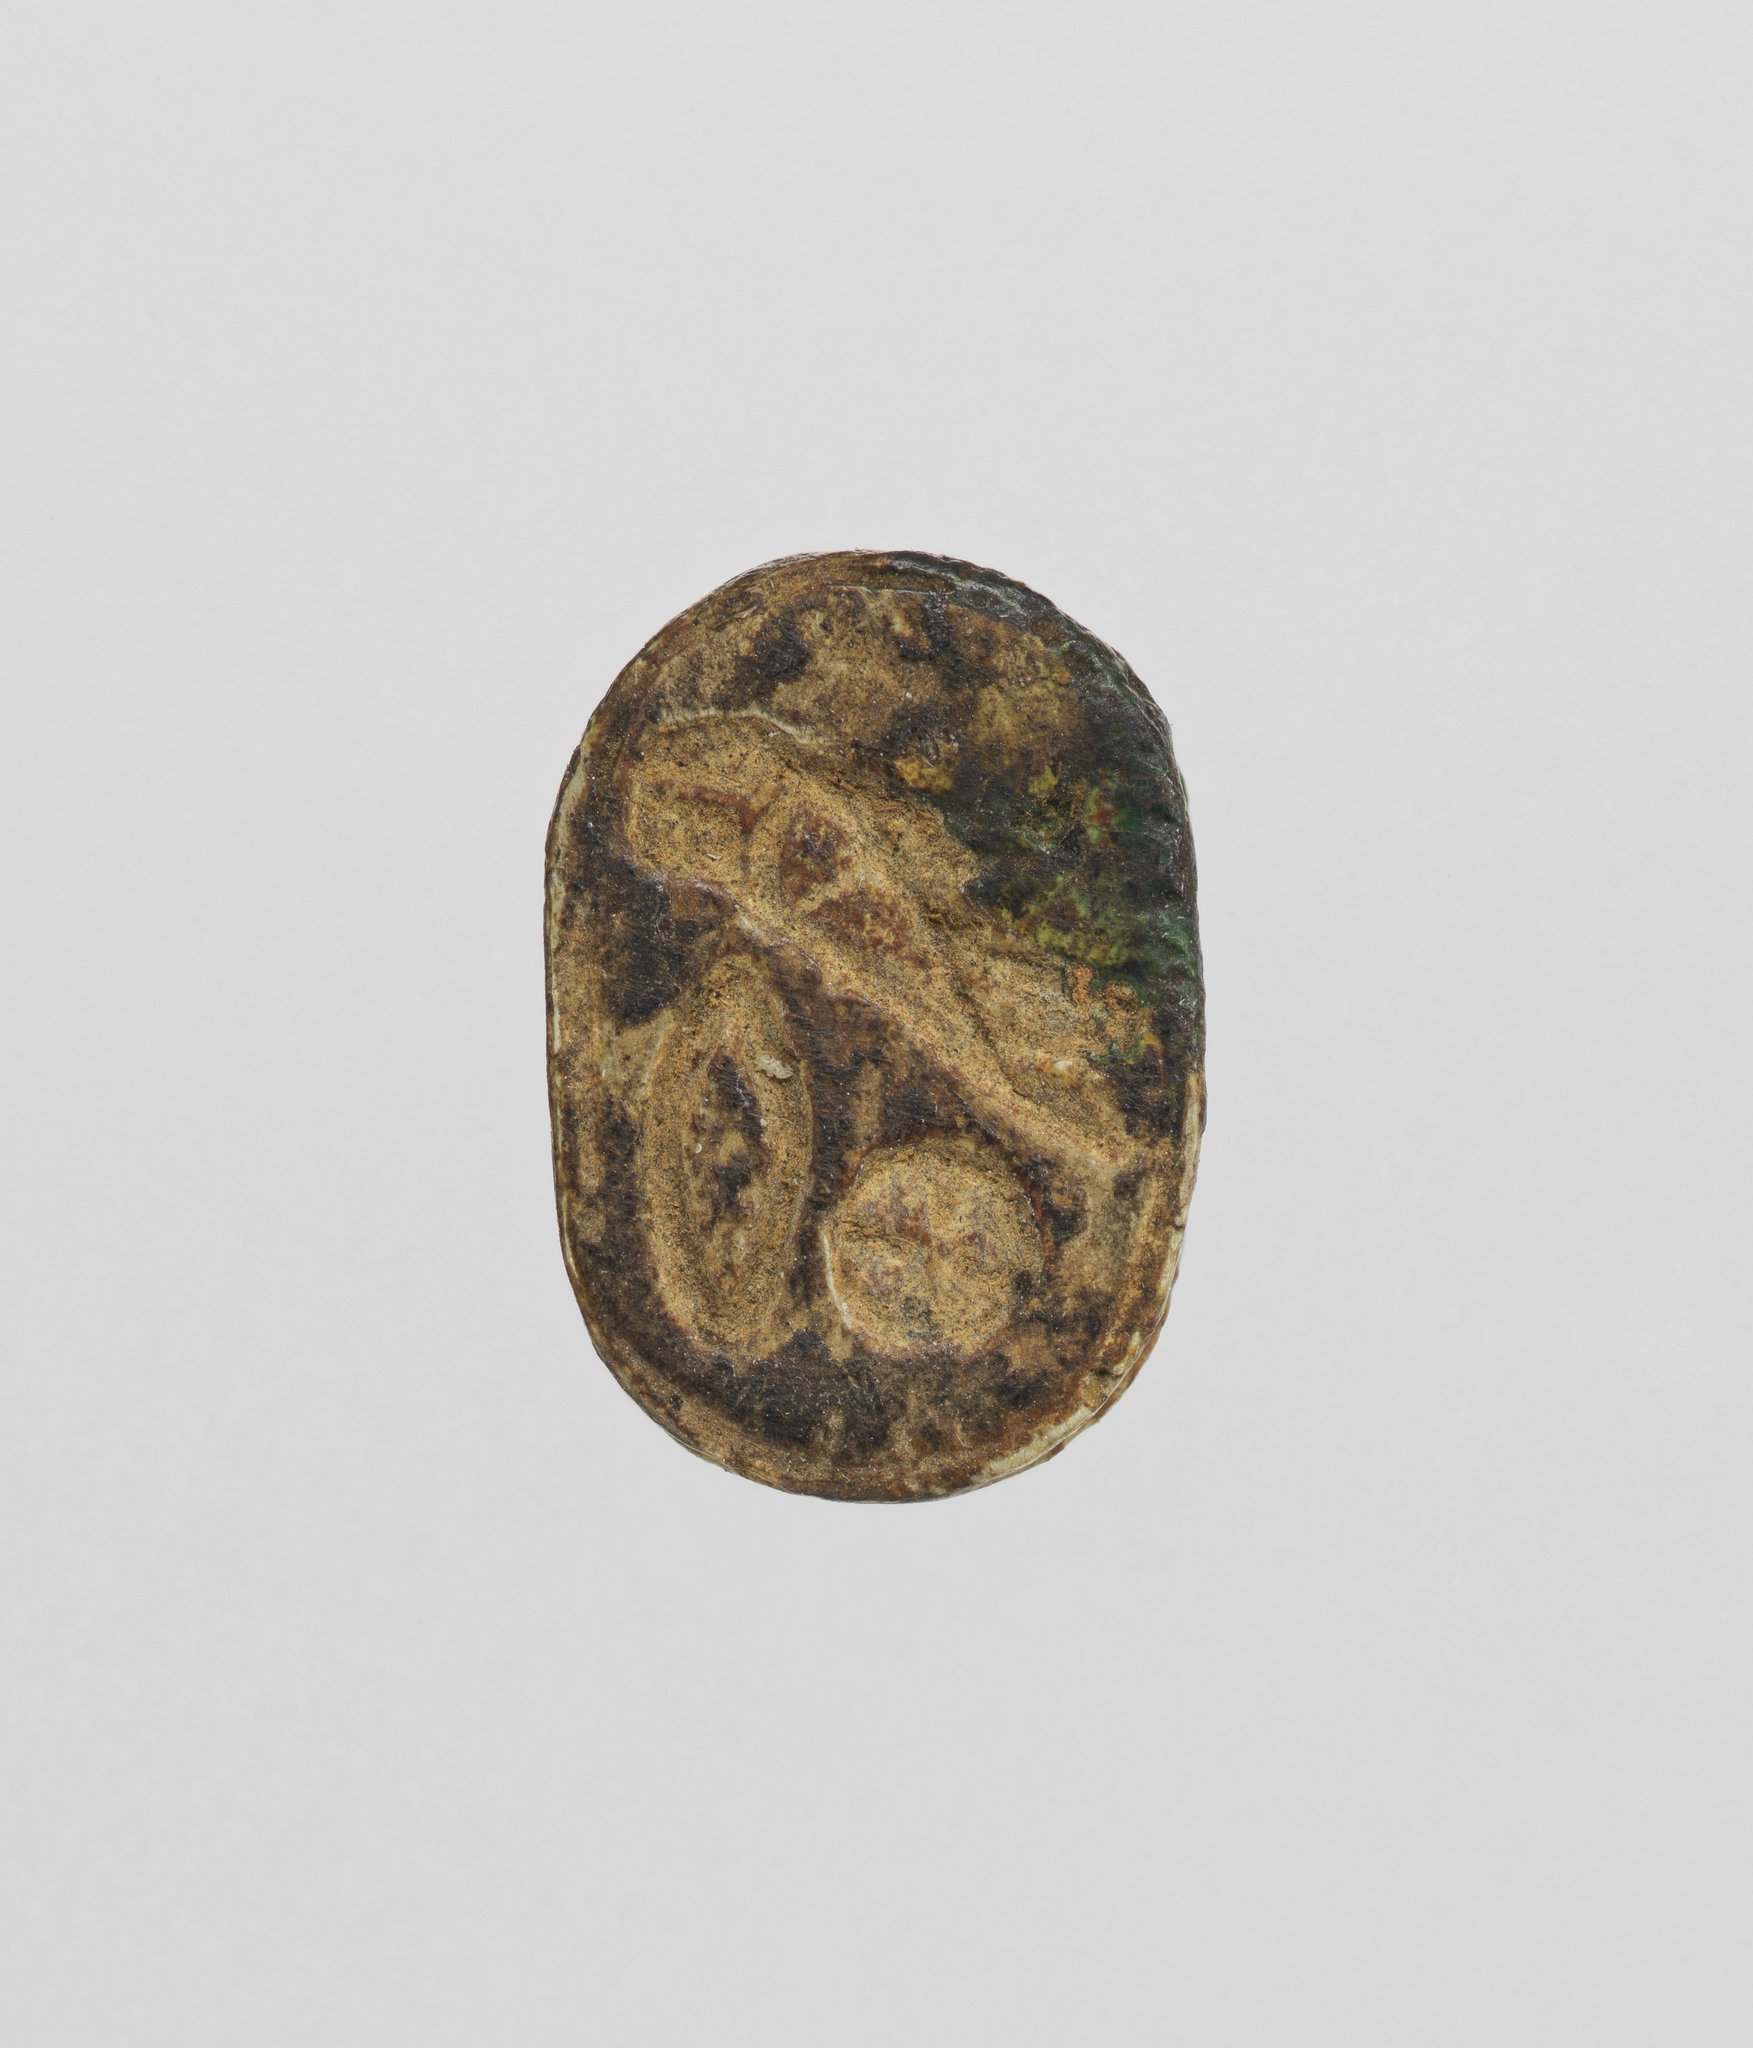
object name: scarab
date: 1295-1070 BCE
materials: stone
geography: egypt